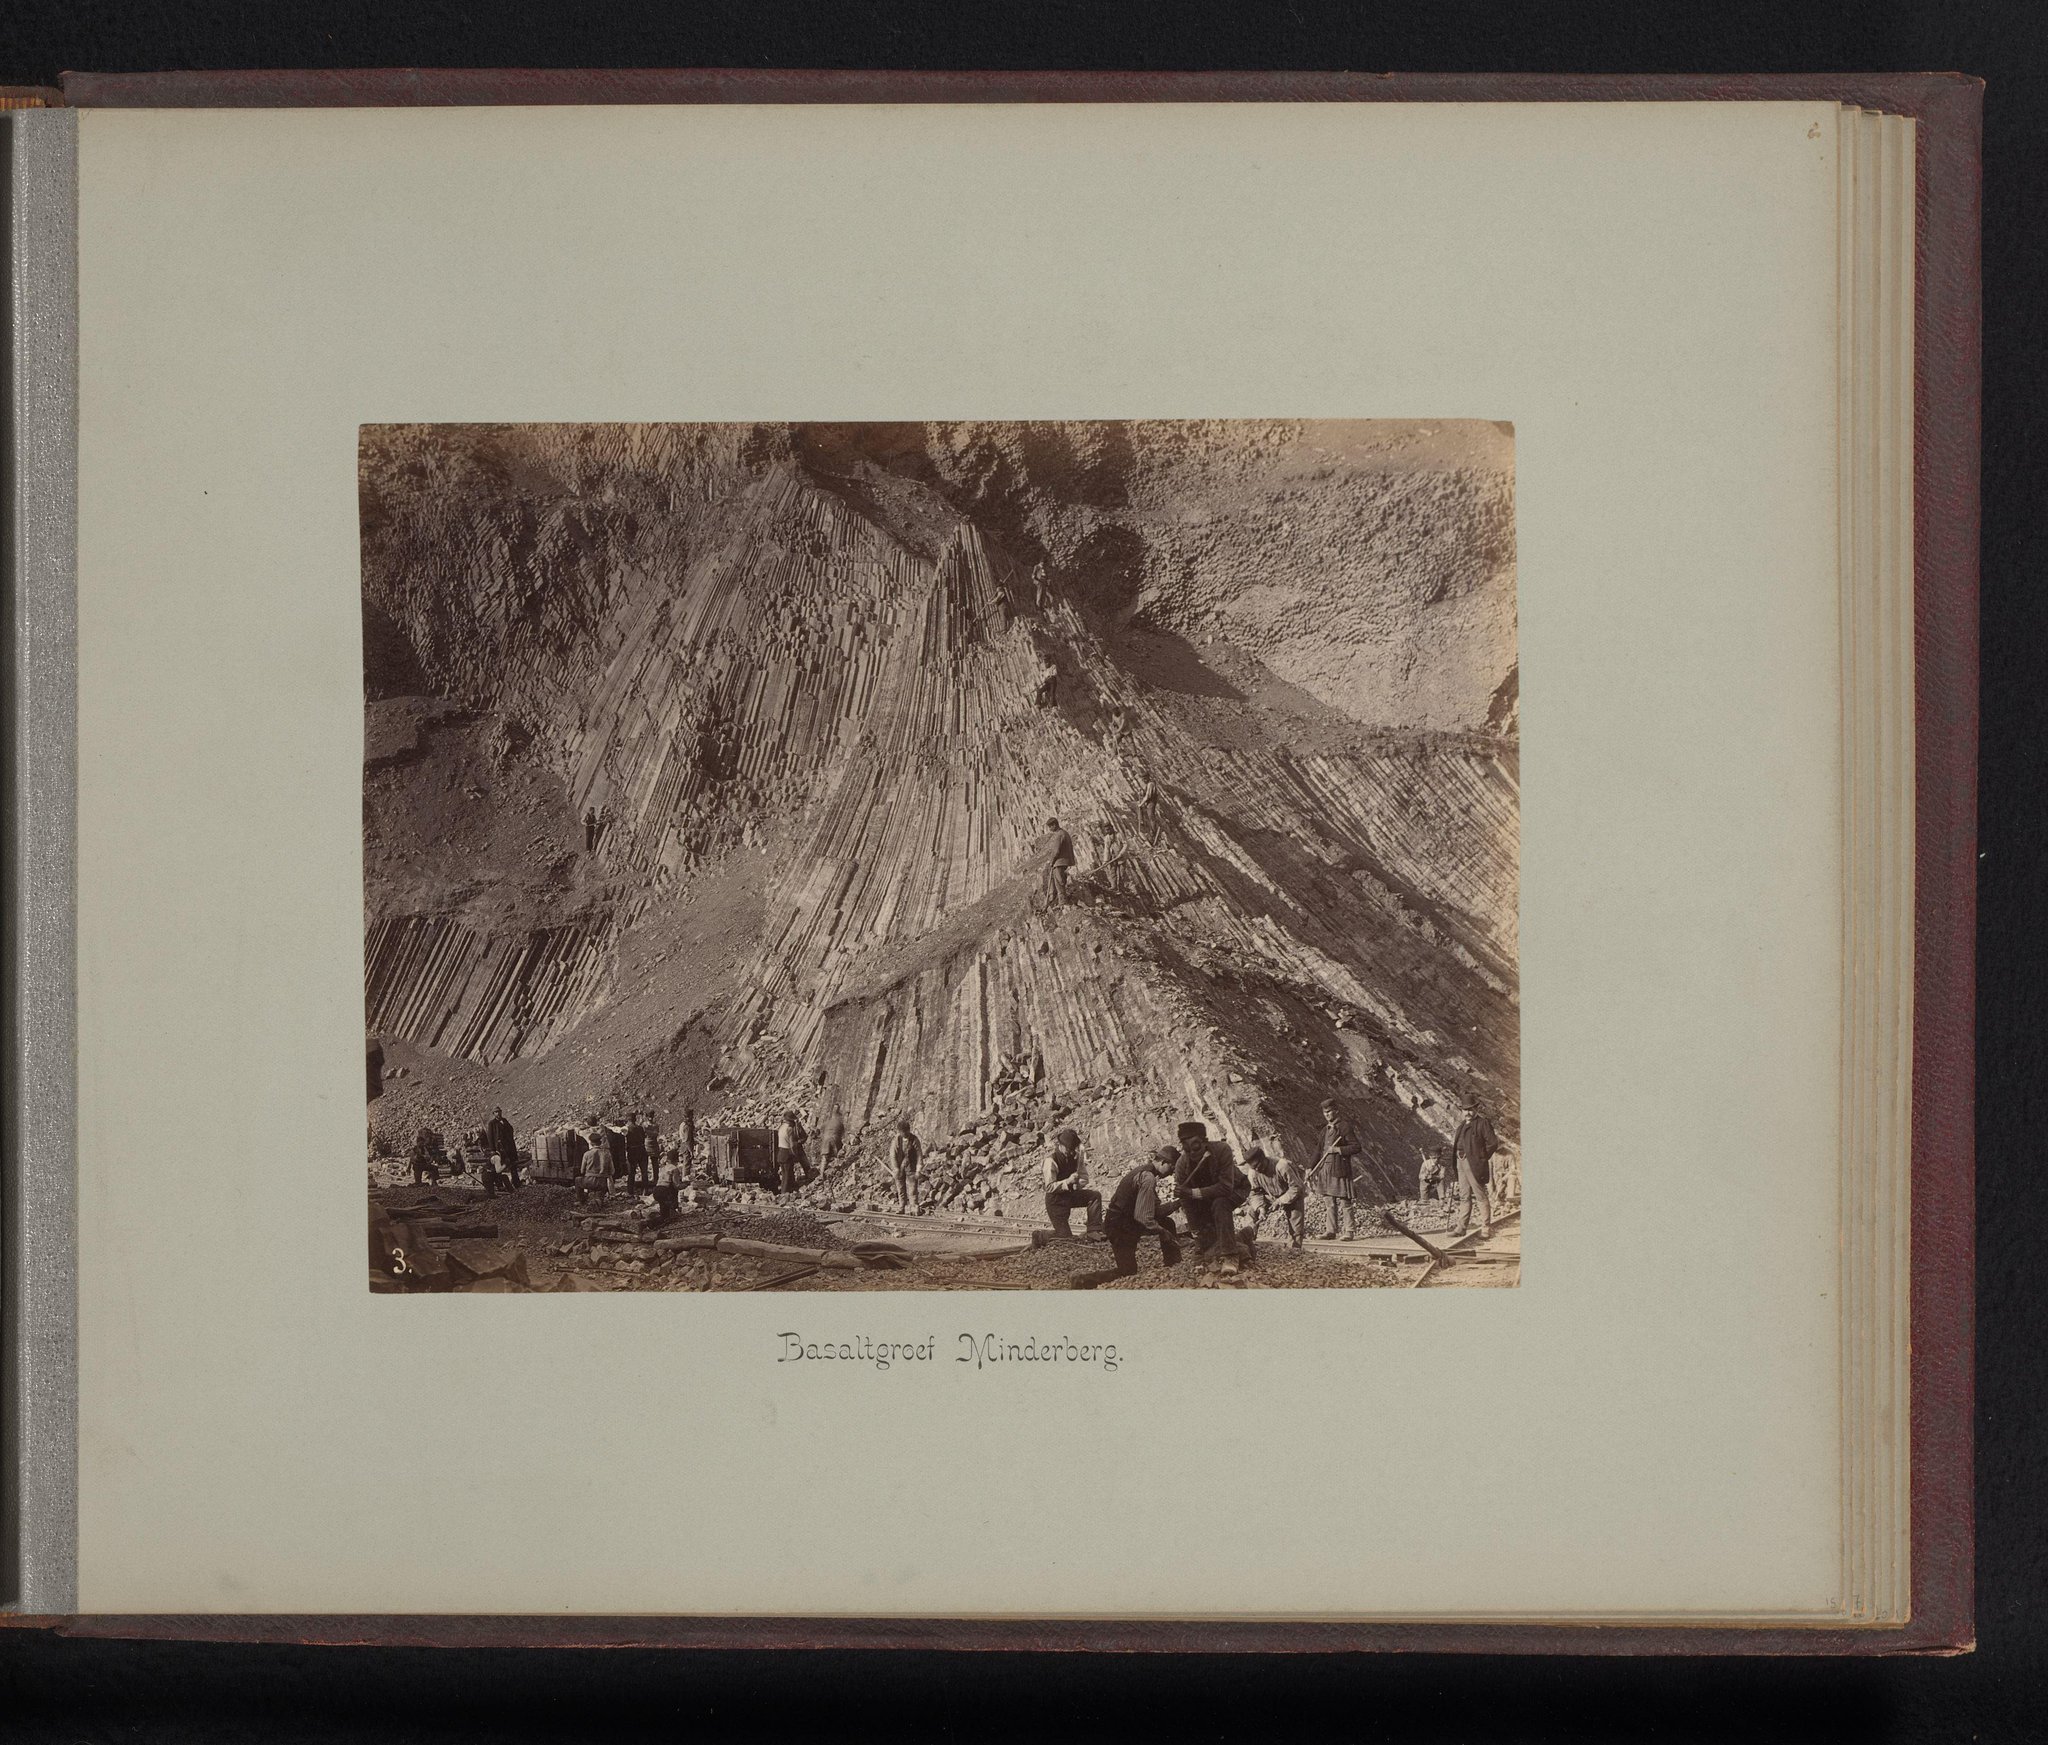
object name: album leaf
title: Basaltgroef Minderberg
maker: Anonymous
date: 1883-1900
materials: cardboard, photographic support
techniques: albumen print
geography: rhineland-palatinate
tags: quarry (+ stone), working class, labourers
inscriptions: number: ‘3.’